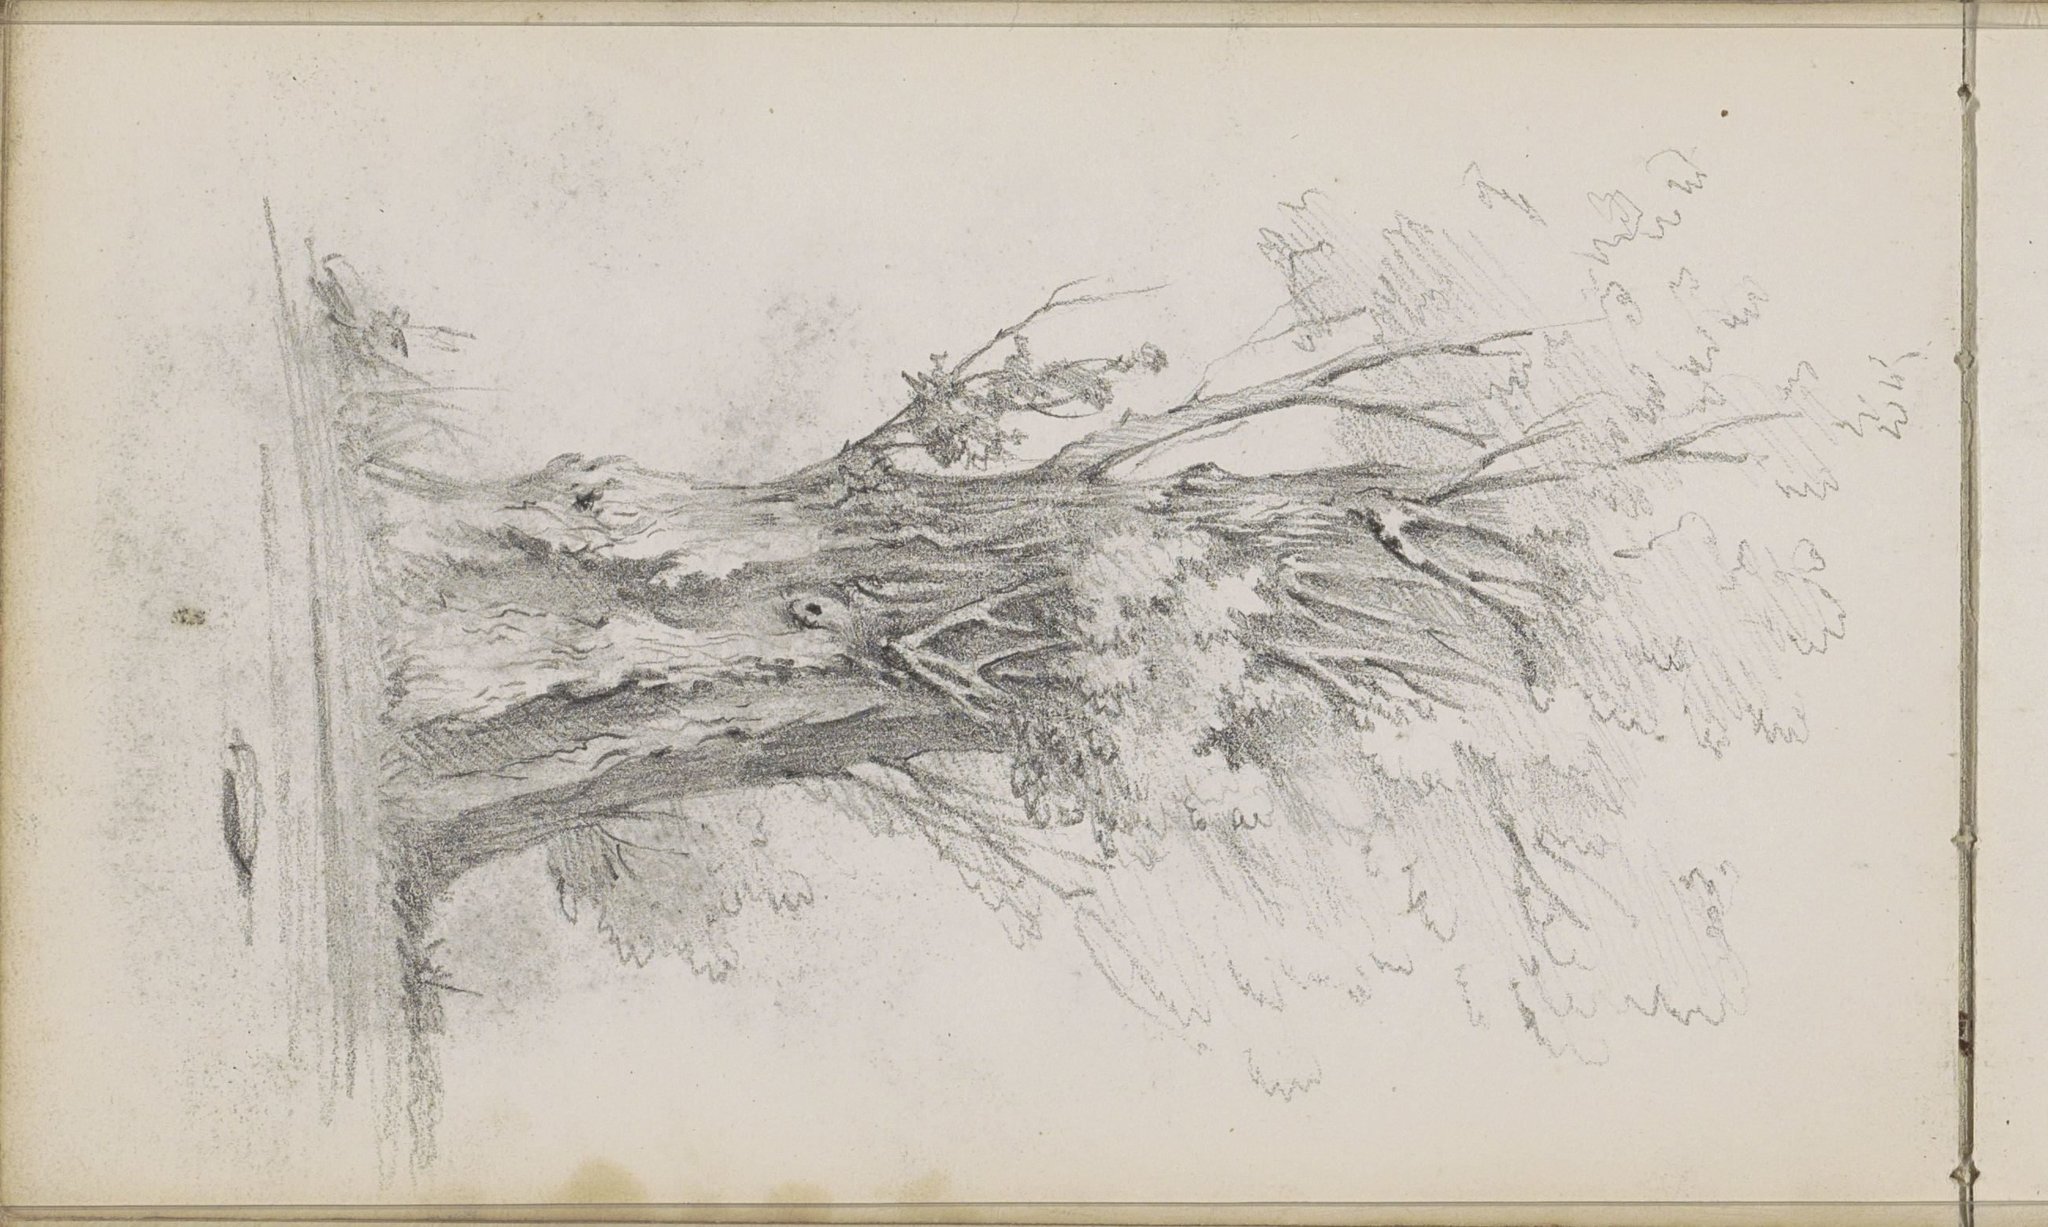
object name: sketchbook leaf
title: Boom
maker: willem cornelis rip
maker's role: draughtsman, painter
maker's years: 1856-1922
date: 1874-1875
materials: paper, pencil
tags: trees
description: Blad 34 verso uit een schetsboek met 46 bladen.